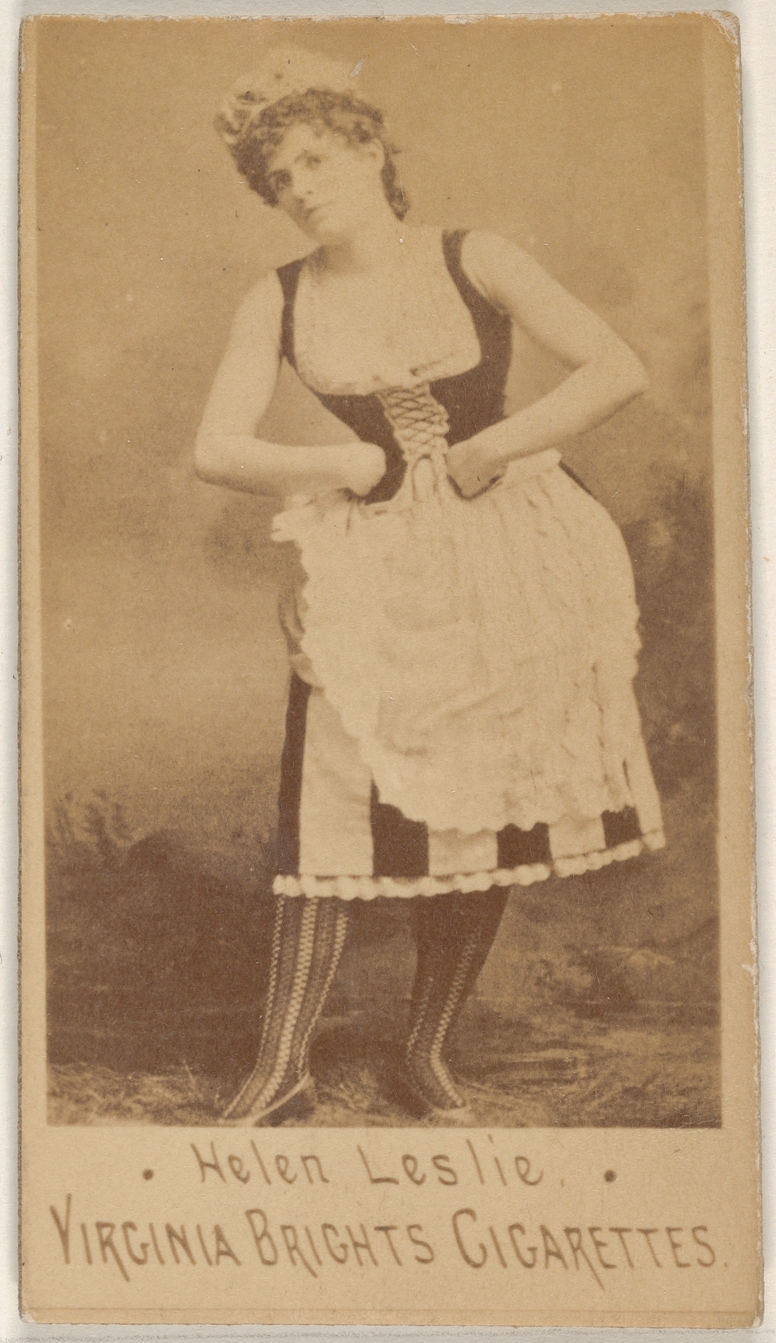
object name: photograph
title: Helen Leslie, from the Actors and Actresses series (N45, Type 1) for Virginia Brights Cigarettes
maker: allen & ginter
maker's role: publisher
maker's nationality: american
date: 1888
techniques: albumen silver print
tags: portraits,women,actresses